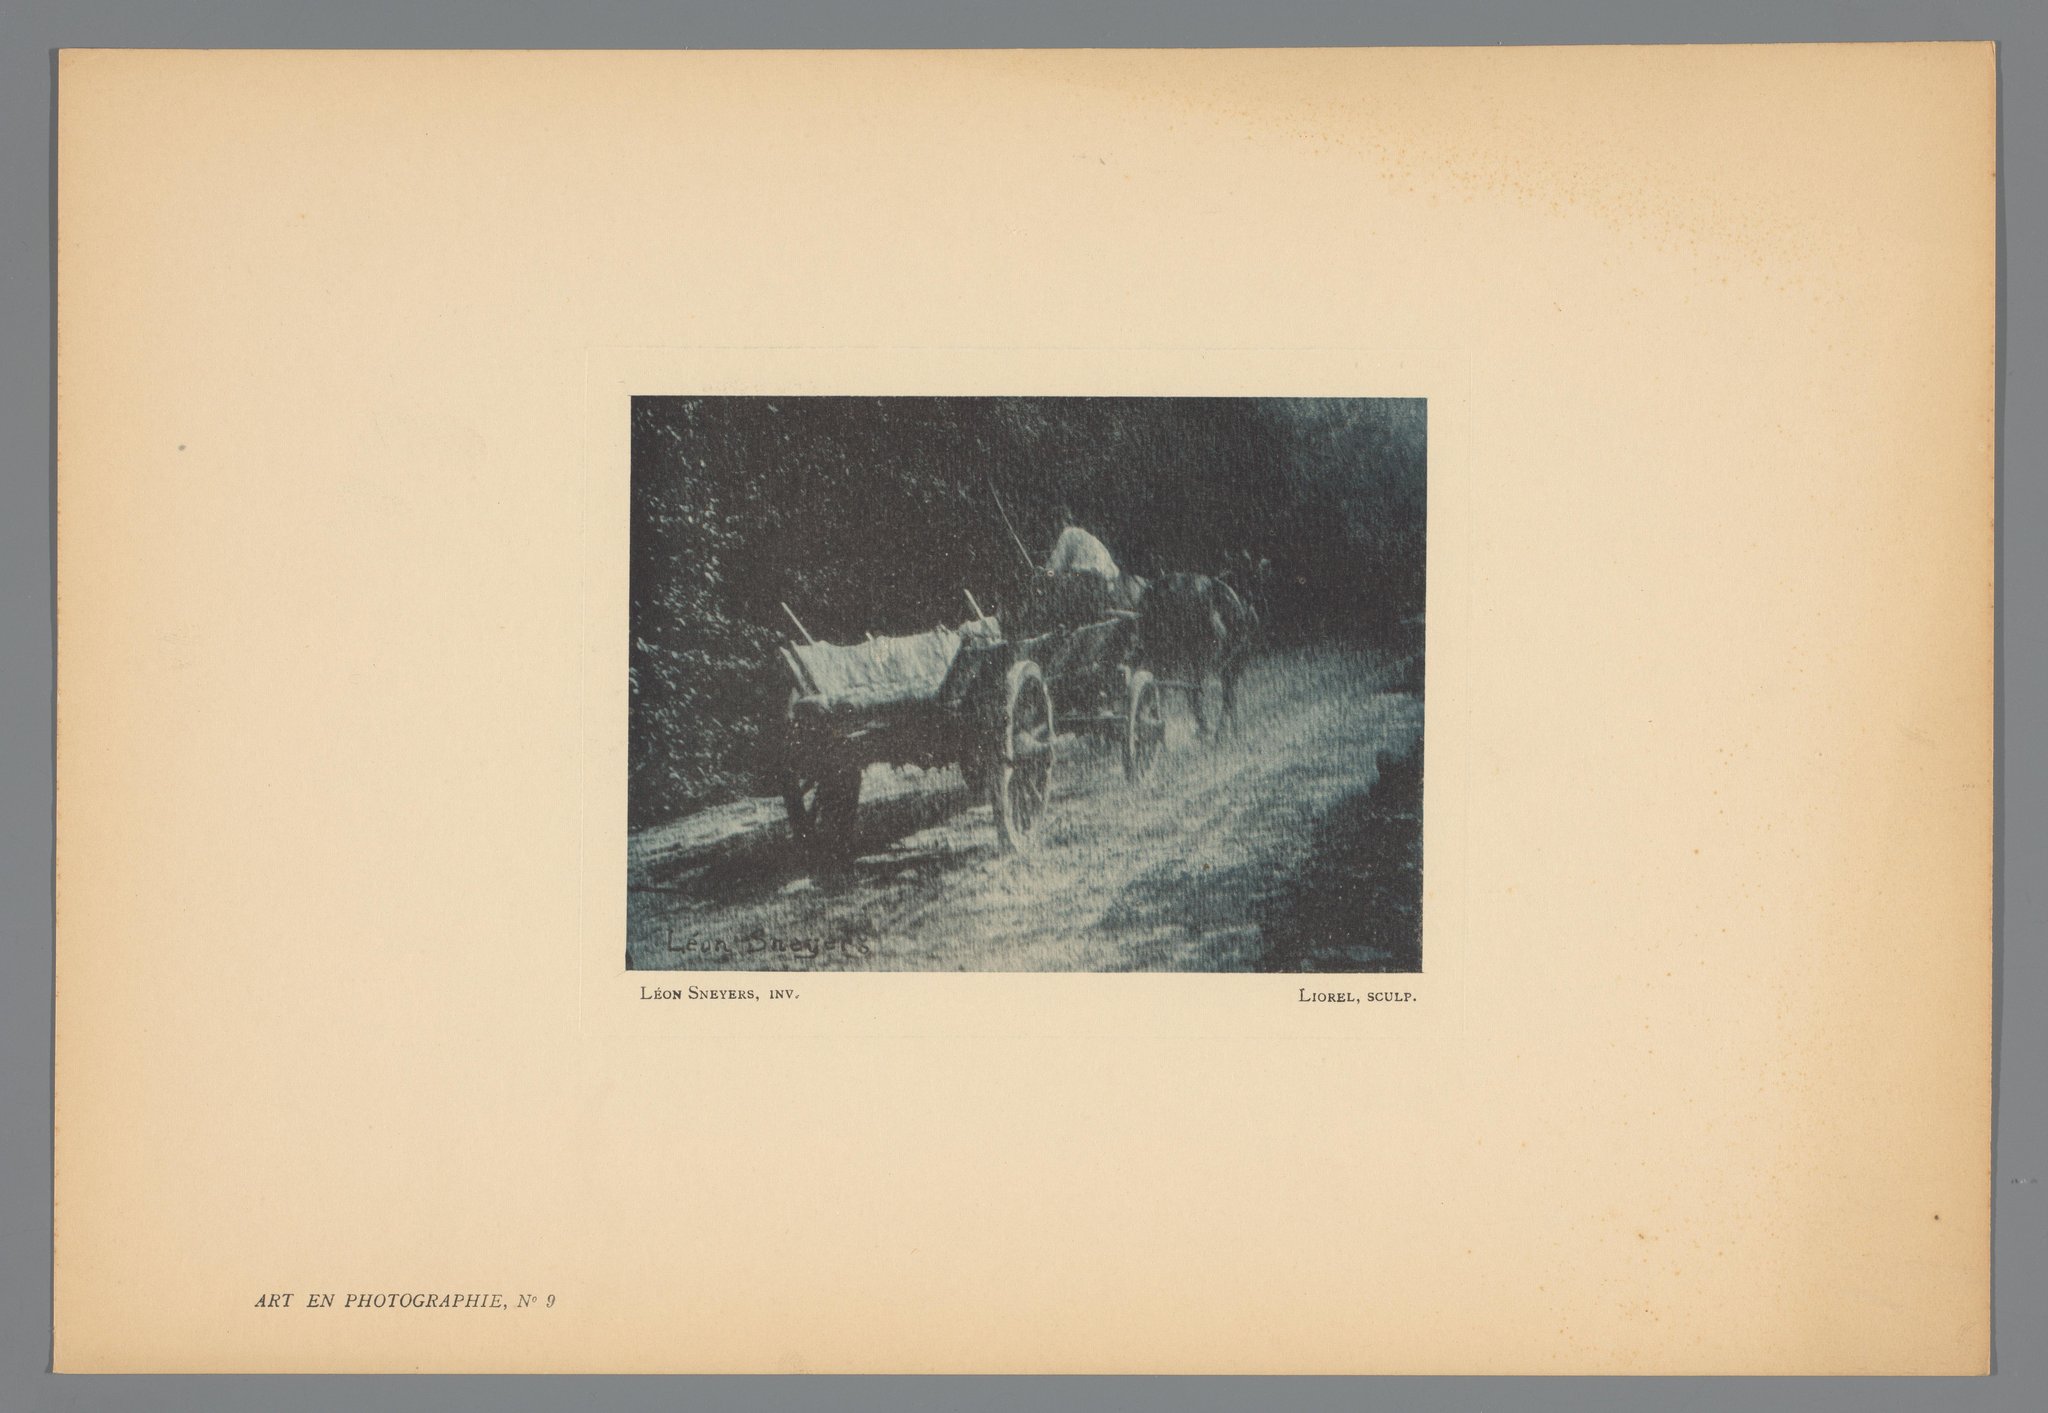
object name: photomechanical print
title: Boer met paard en wagen op een landweg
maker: léon sneyers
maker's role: architect, fotograaf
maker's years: 1877-1949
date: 1896-1901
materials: paper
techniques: photograph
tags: farmers, road, path, four-wheeled vehicle drawn by two animals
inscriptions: inscription: ‘ART EN PHOTOGRAPHIE, No 9’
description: Deze prent maakt deel uit van een omslag met 54 prenten op 52 bladen.